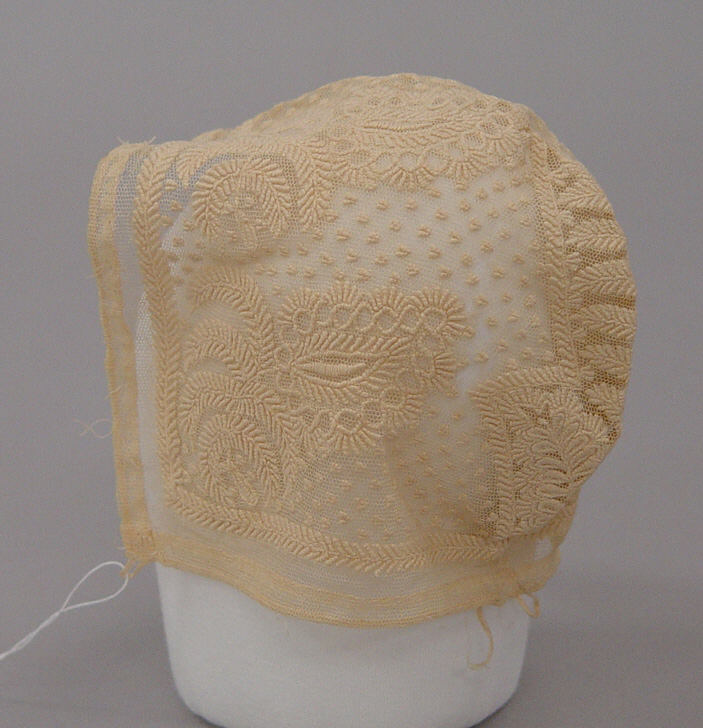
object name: cap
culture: american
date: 1800-1850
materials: cotton